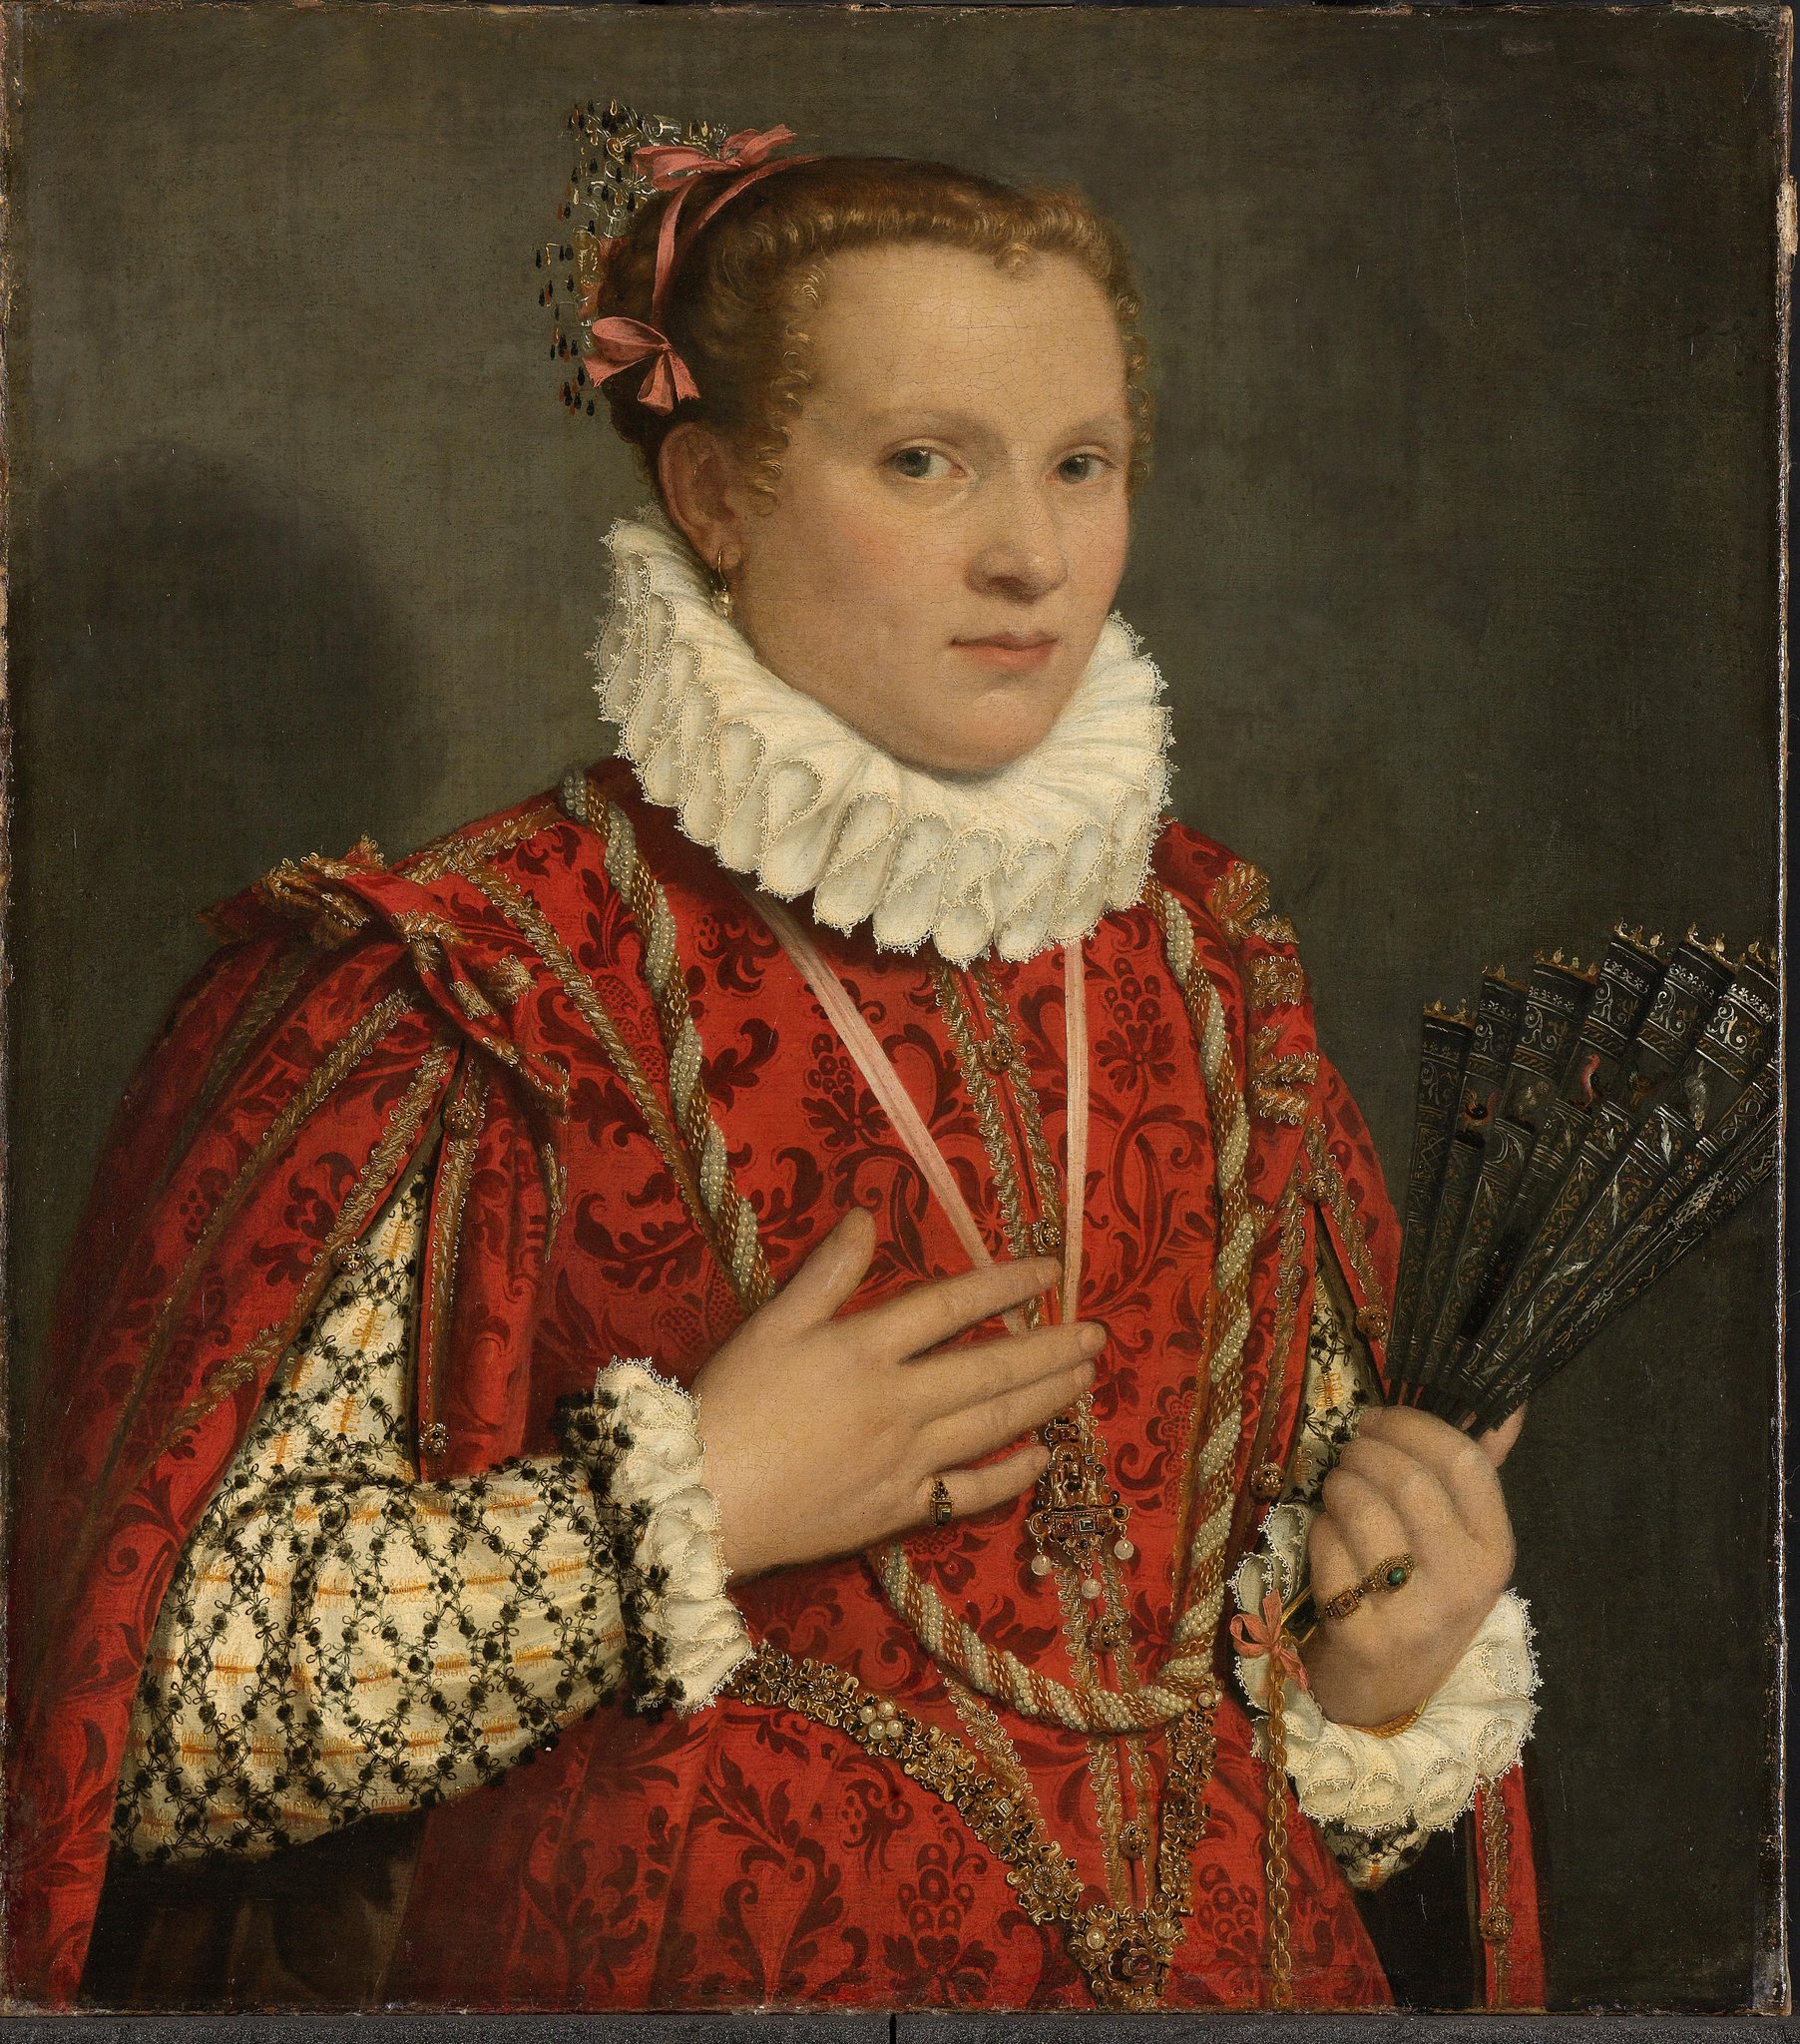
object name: painting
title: Portrait of a young Woman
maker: giambattista moroni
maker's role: painter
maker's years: 1525-1578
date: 1560-1578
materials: canvas, oil, paint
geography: bergamo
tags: fan, anonymous historical person portrayed - bb - woman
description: Much of Moroni’s career was passed in the provincial town of Bergamo in North Italy. He specialized in portraiture. The directness and warm sympathy with which he portrayed his sitters, whatever their rank, places him among the foremost practitioners of his age. This woman’s sumptuous clothing and costly jewels proclaim her social status, but there is alas no clue to her identity.